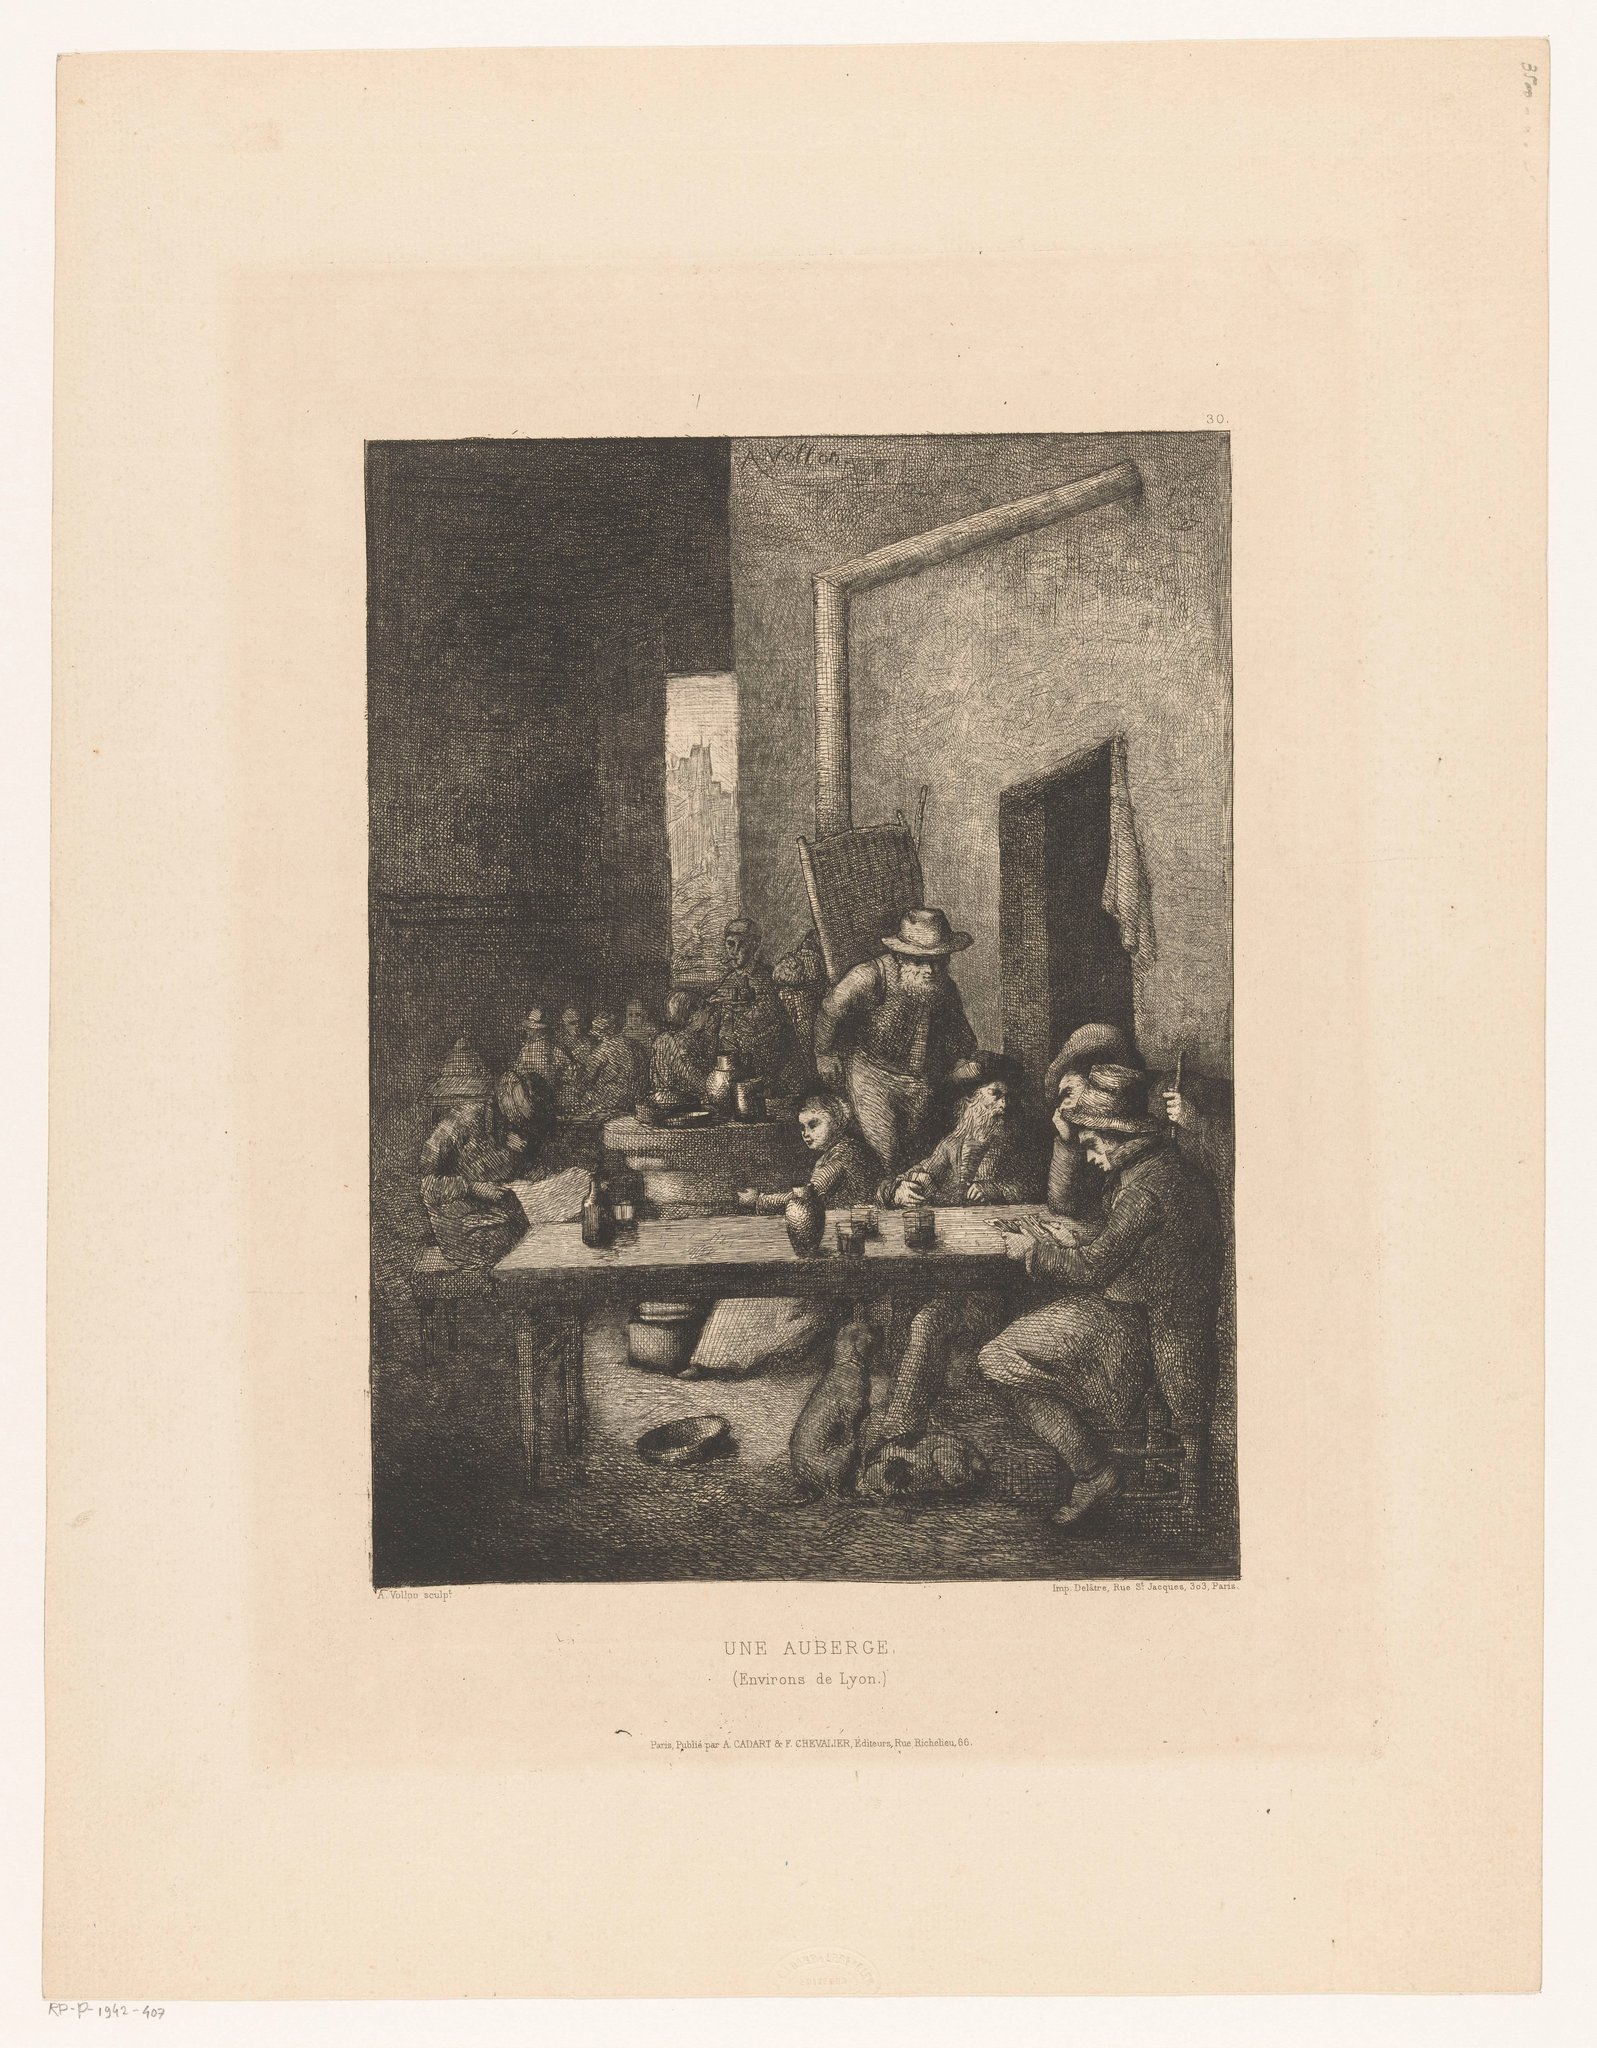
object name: print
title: Figuren in een herberg in de buurt van Lyon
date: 1863-1942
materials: paper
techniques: drypoint, etching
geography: france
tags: inn, coffee-house, public house, etc., dog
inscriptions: collector's mark: Lugt 88a, check stamp: Lugt 3270, collector's mark: Lugt 2228, collector's mark: Lugt 2760